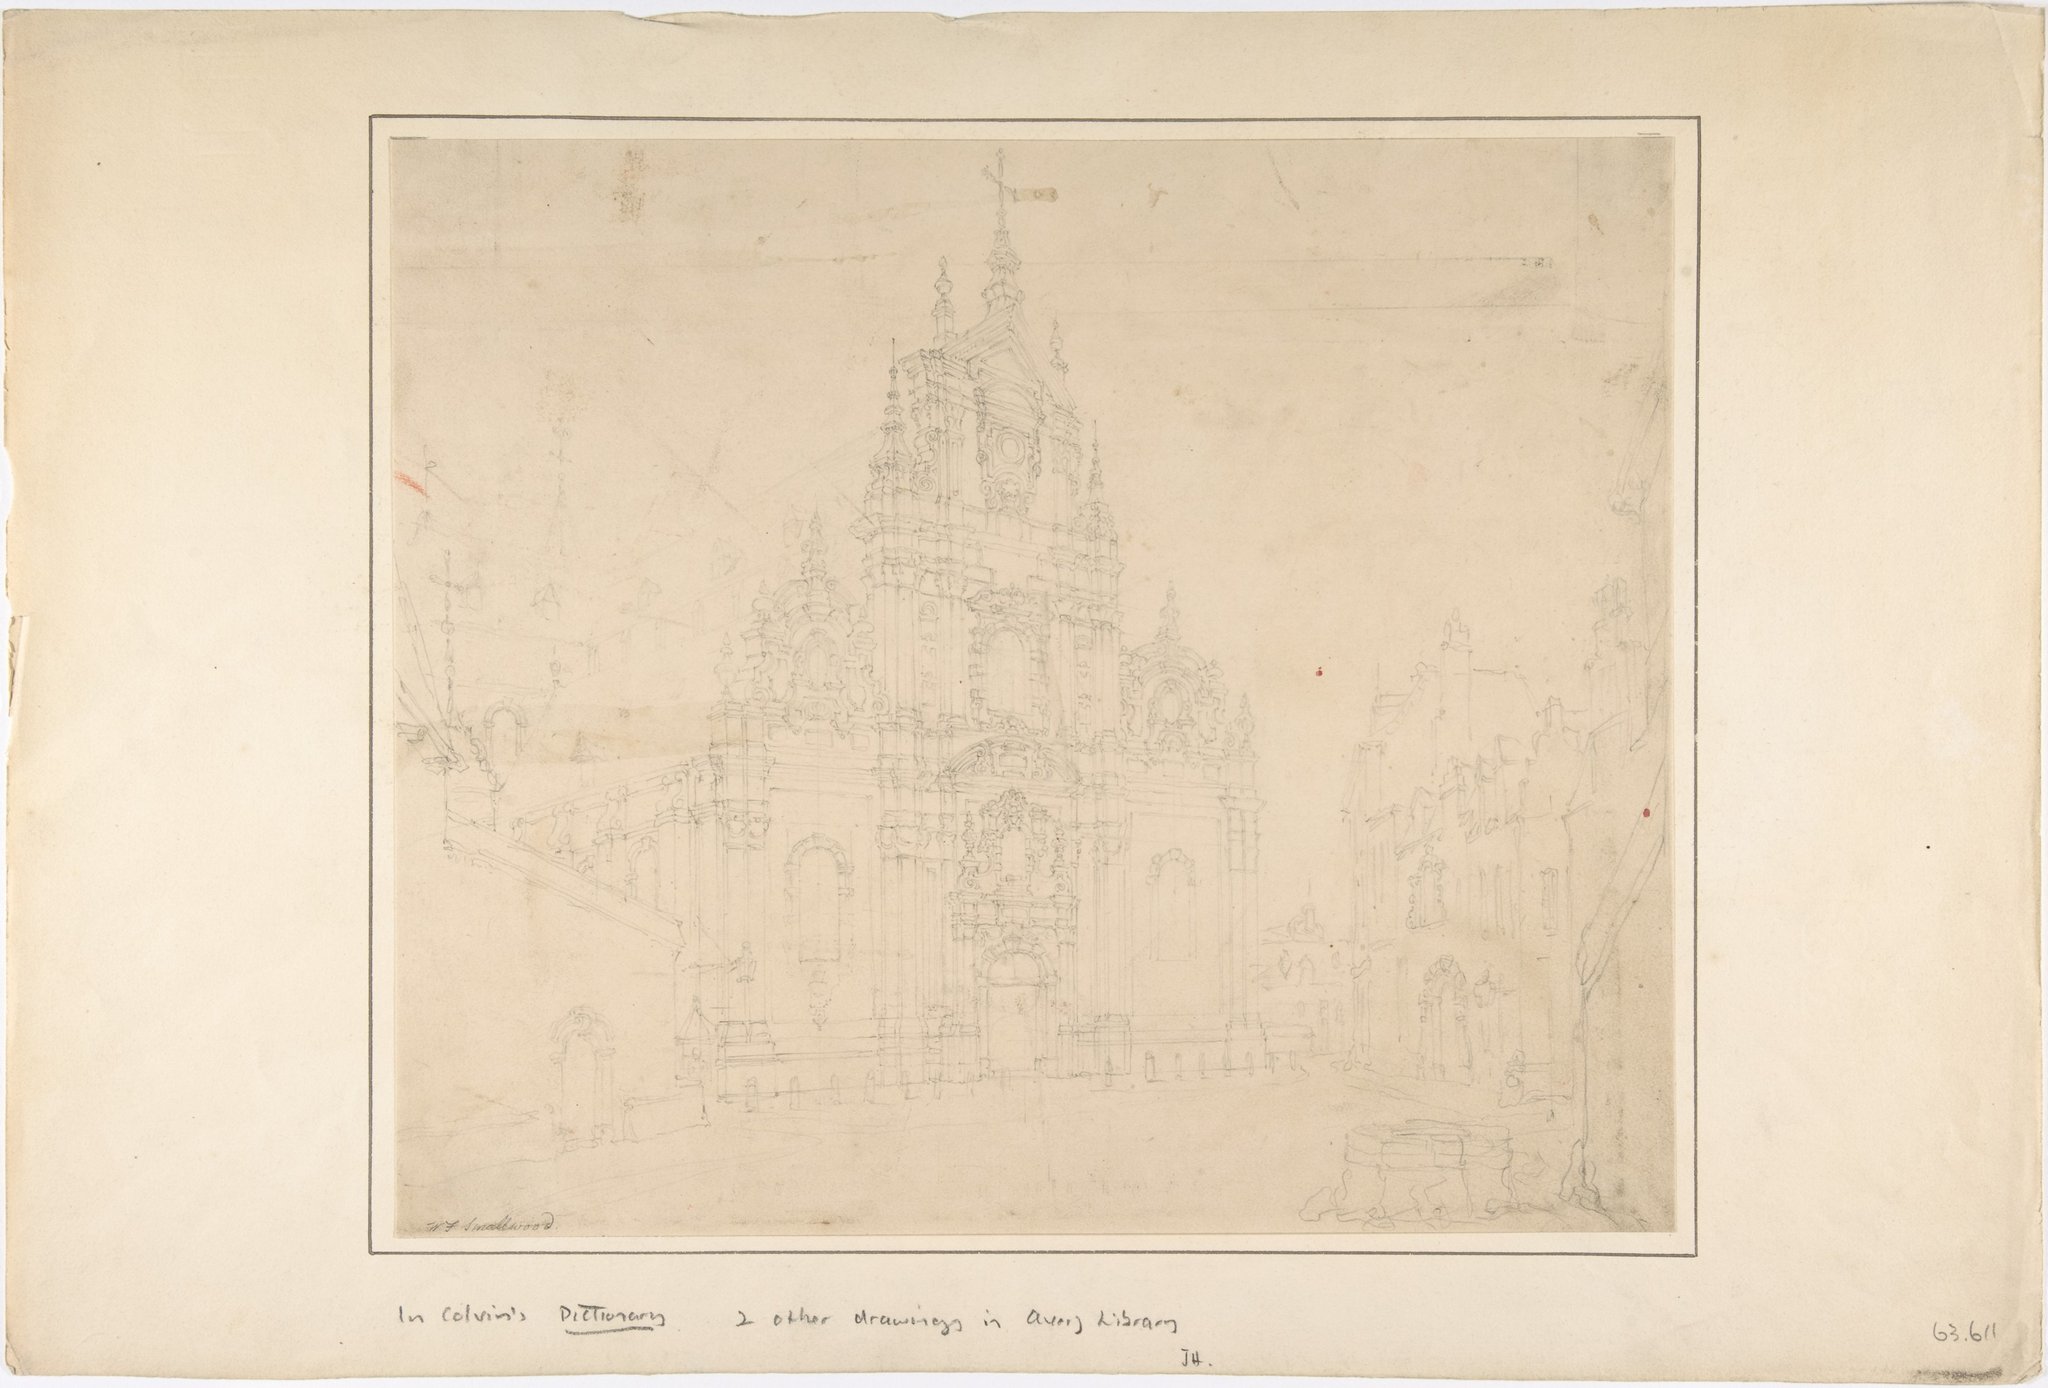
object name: drawing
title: Church of St. John the Baptist at the Béguinage, Brussels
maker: william frome smallwood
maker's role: artist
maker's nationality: british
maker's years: 1806-1834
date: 1824-1834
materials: graphite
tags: architecture,churches